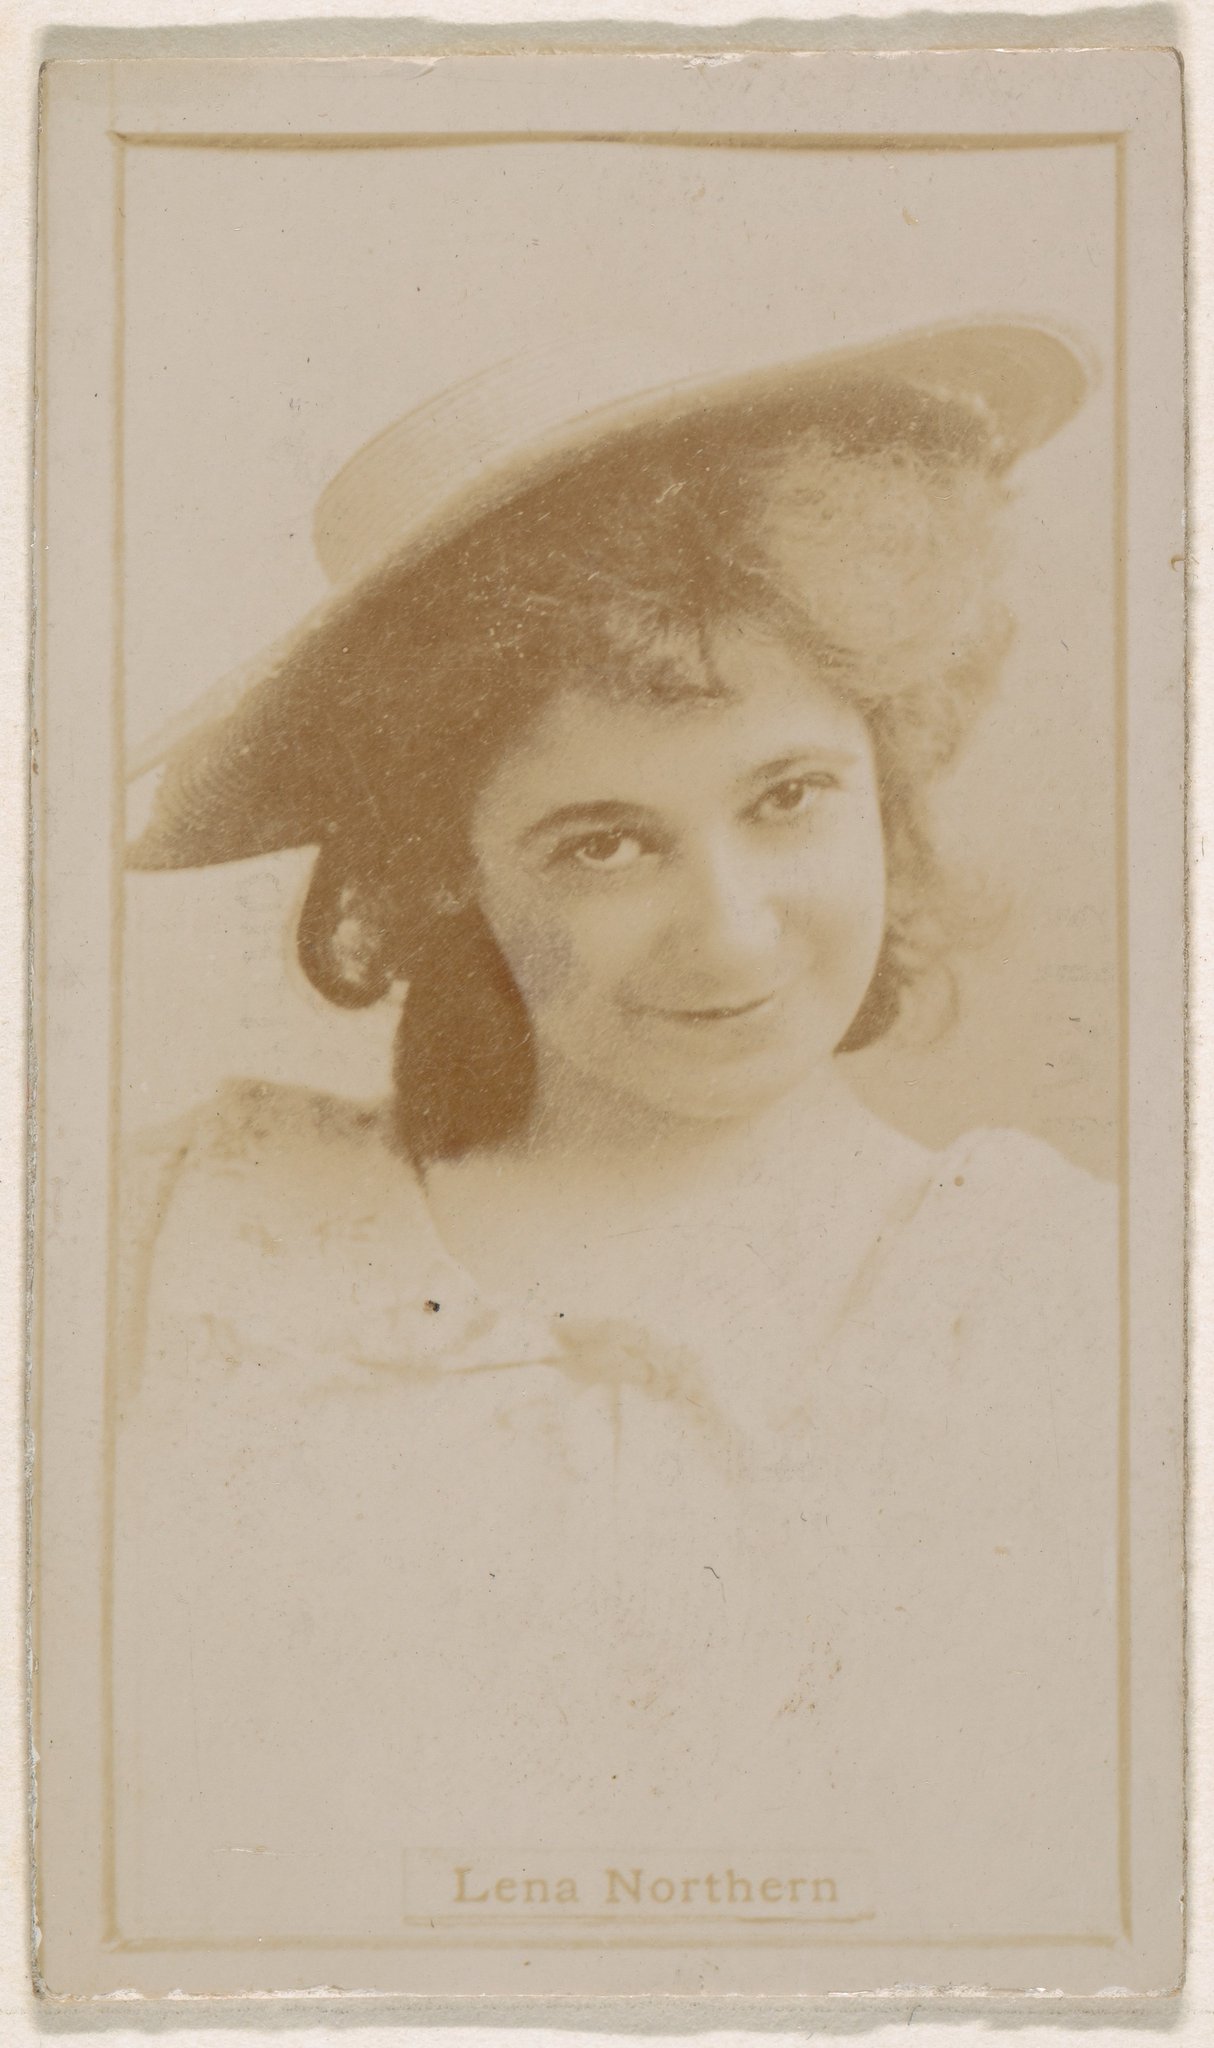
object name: photograph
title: Lena Northern, from the Actresses series (N245) issued by Kinney Brothers to promote Sweet Caporal Cigarettes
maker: kinney brothers tobacco company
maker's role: publisher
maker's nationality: american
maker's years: 1869-2011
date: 1890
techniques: albumen silver print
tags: portraits,women,actresses